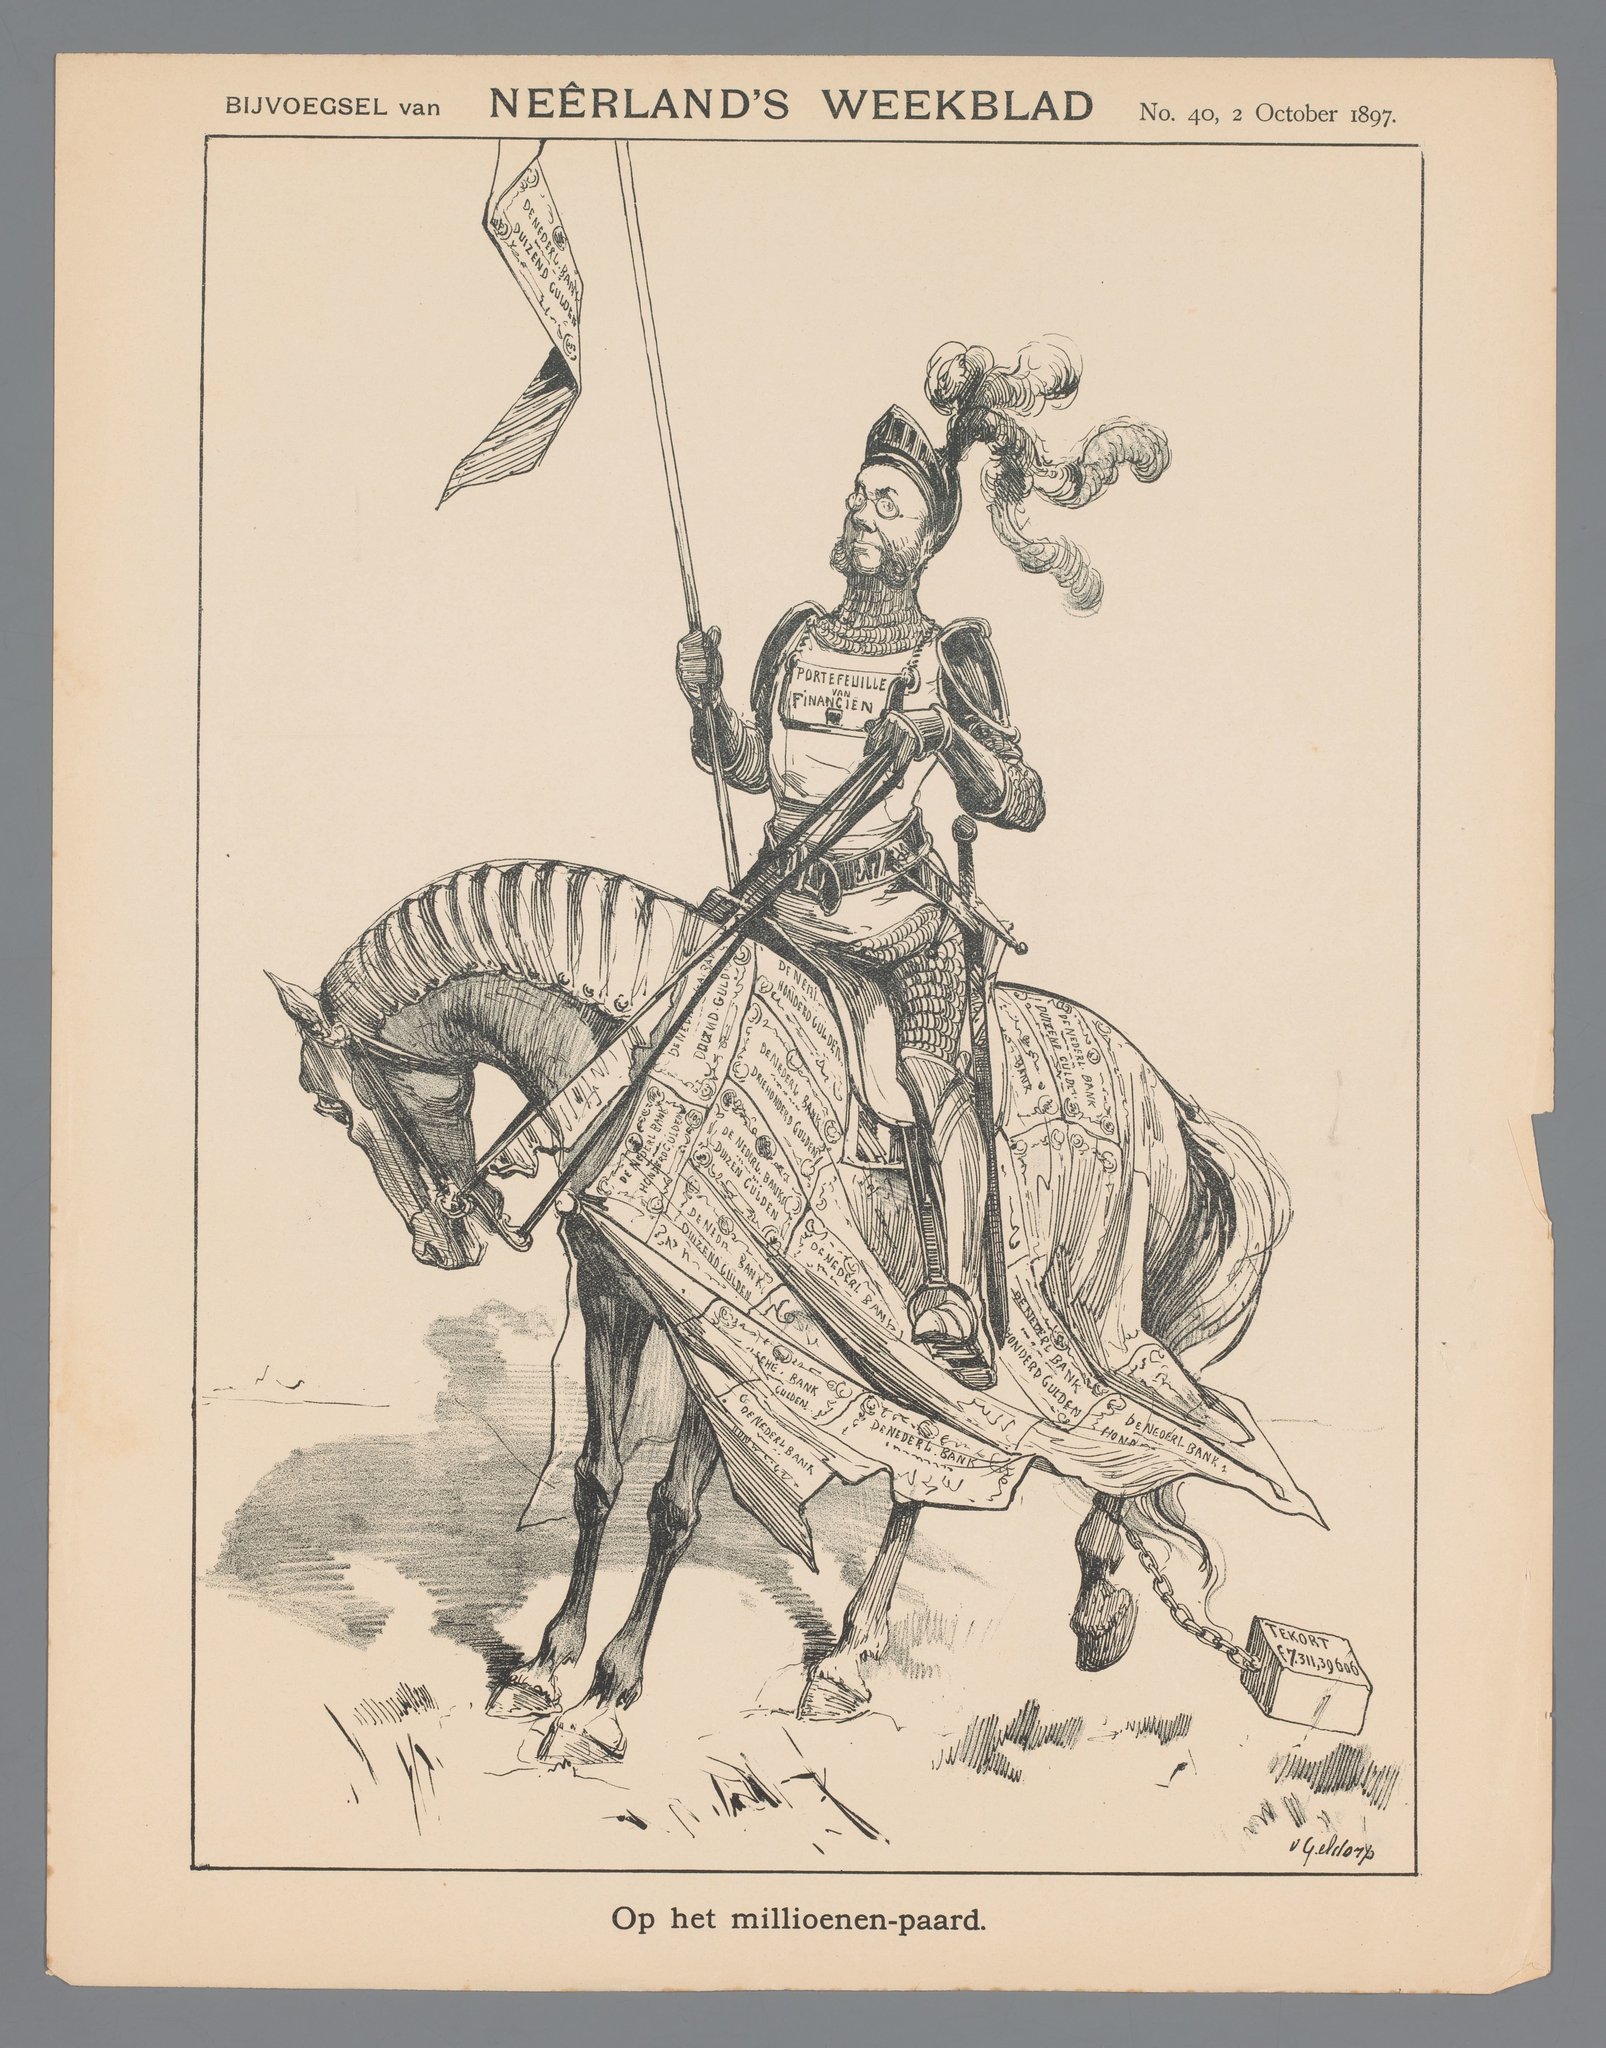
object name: cartoon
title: Op het millioenen-paard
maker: petrus van geldorp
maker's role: draughtsman, print maker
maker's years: 1872-1939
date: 1897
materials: paper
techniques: lithograph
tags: politician, nicolaas gerard pierson, horse, trade, commerce and finance, political caricatures and satires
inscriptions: date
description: Prent uit het bijvoegsel van: Neêrland’s Weekblad, nr. 40, 2 oktober 1897.